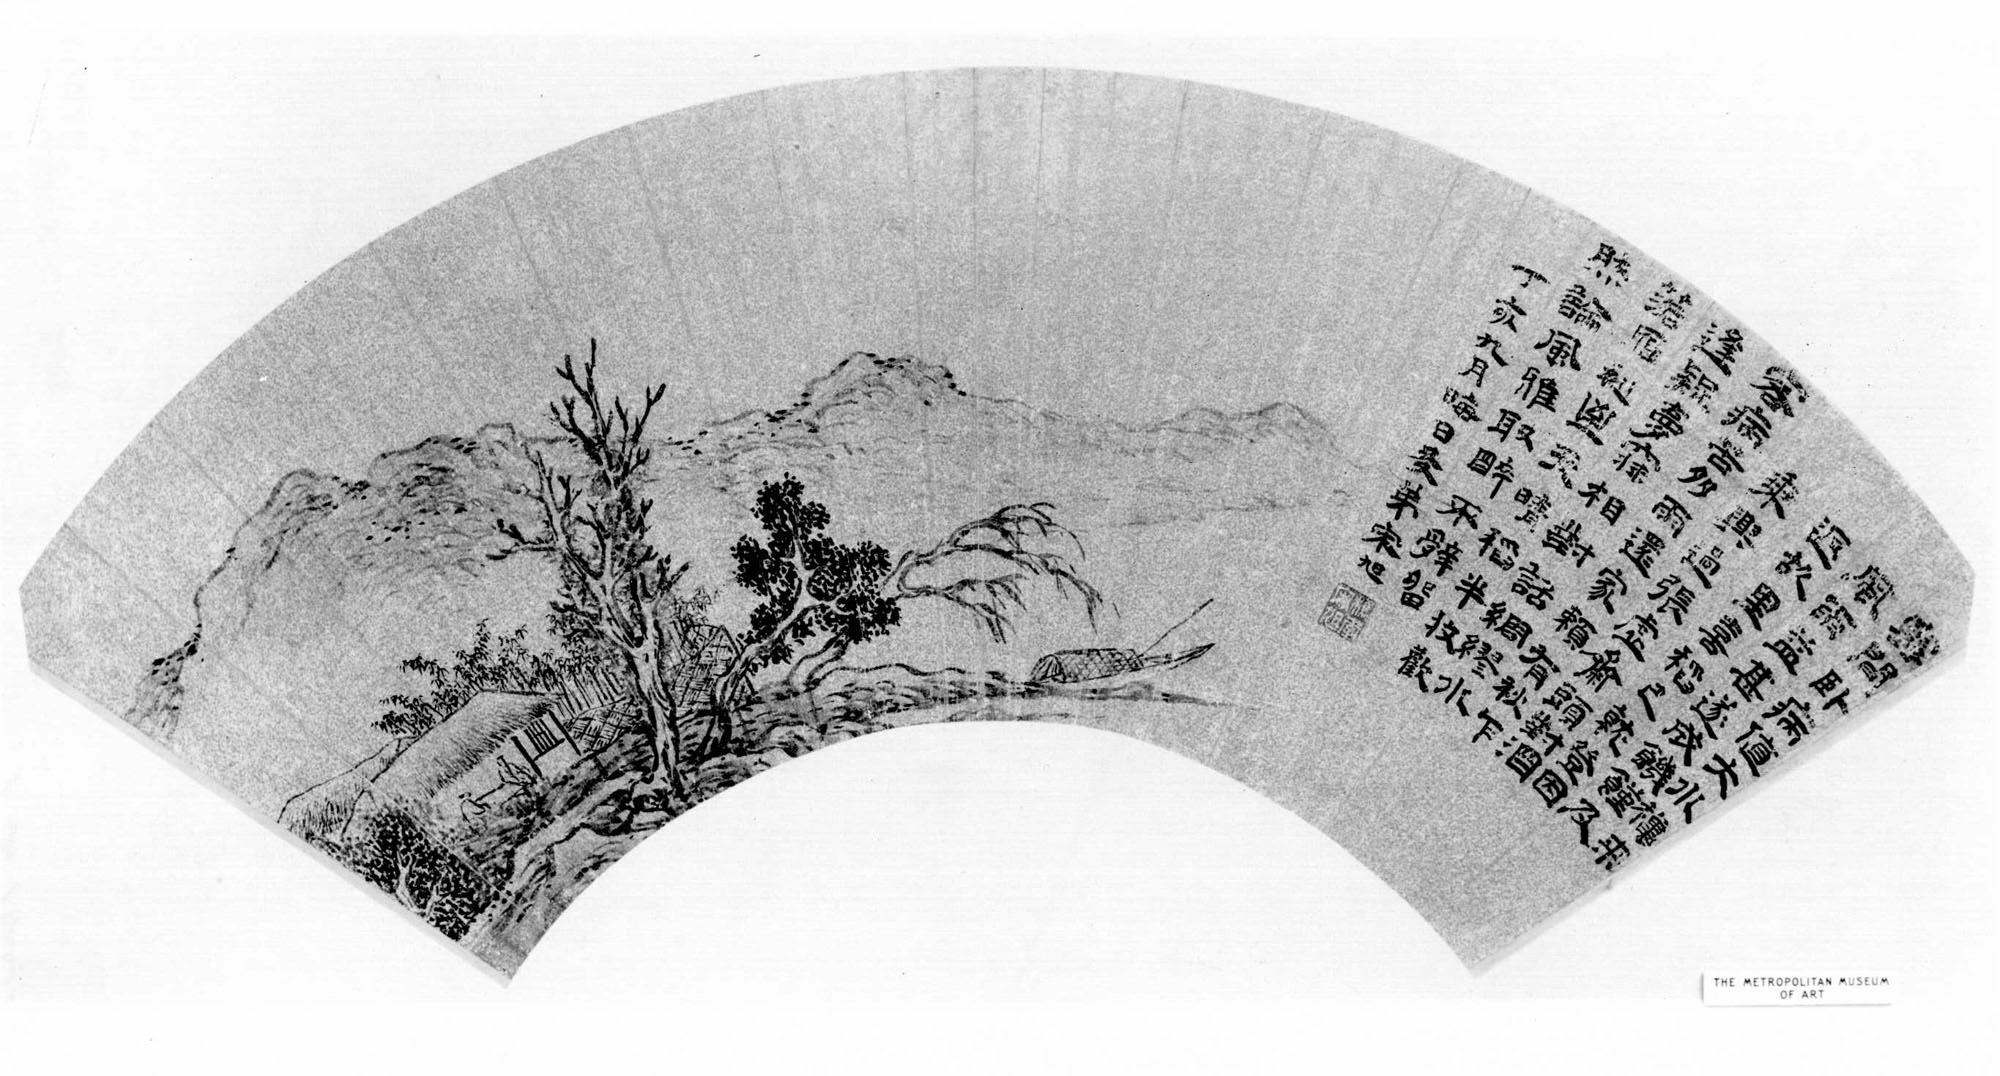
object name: folding fan mounted a an album leaf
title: Landscape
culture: chinese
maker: song xu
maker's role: artist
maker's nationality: chinese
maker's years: 1525-1610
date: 1587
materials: gold, ink, paper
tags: landscapes